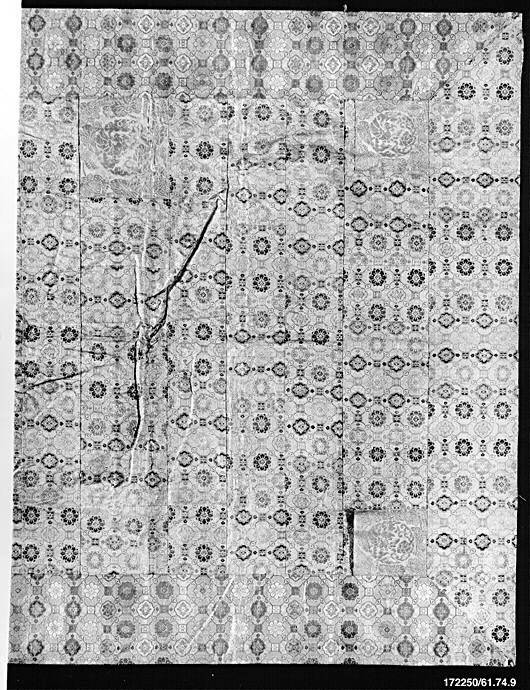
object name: robe, priest's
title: Priest's Robe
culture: japanese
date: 1701-1800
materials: metal thread, silk